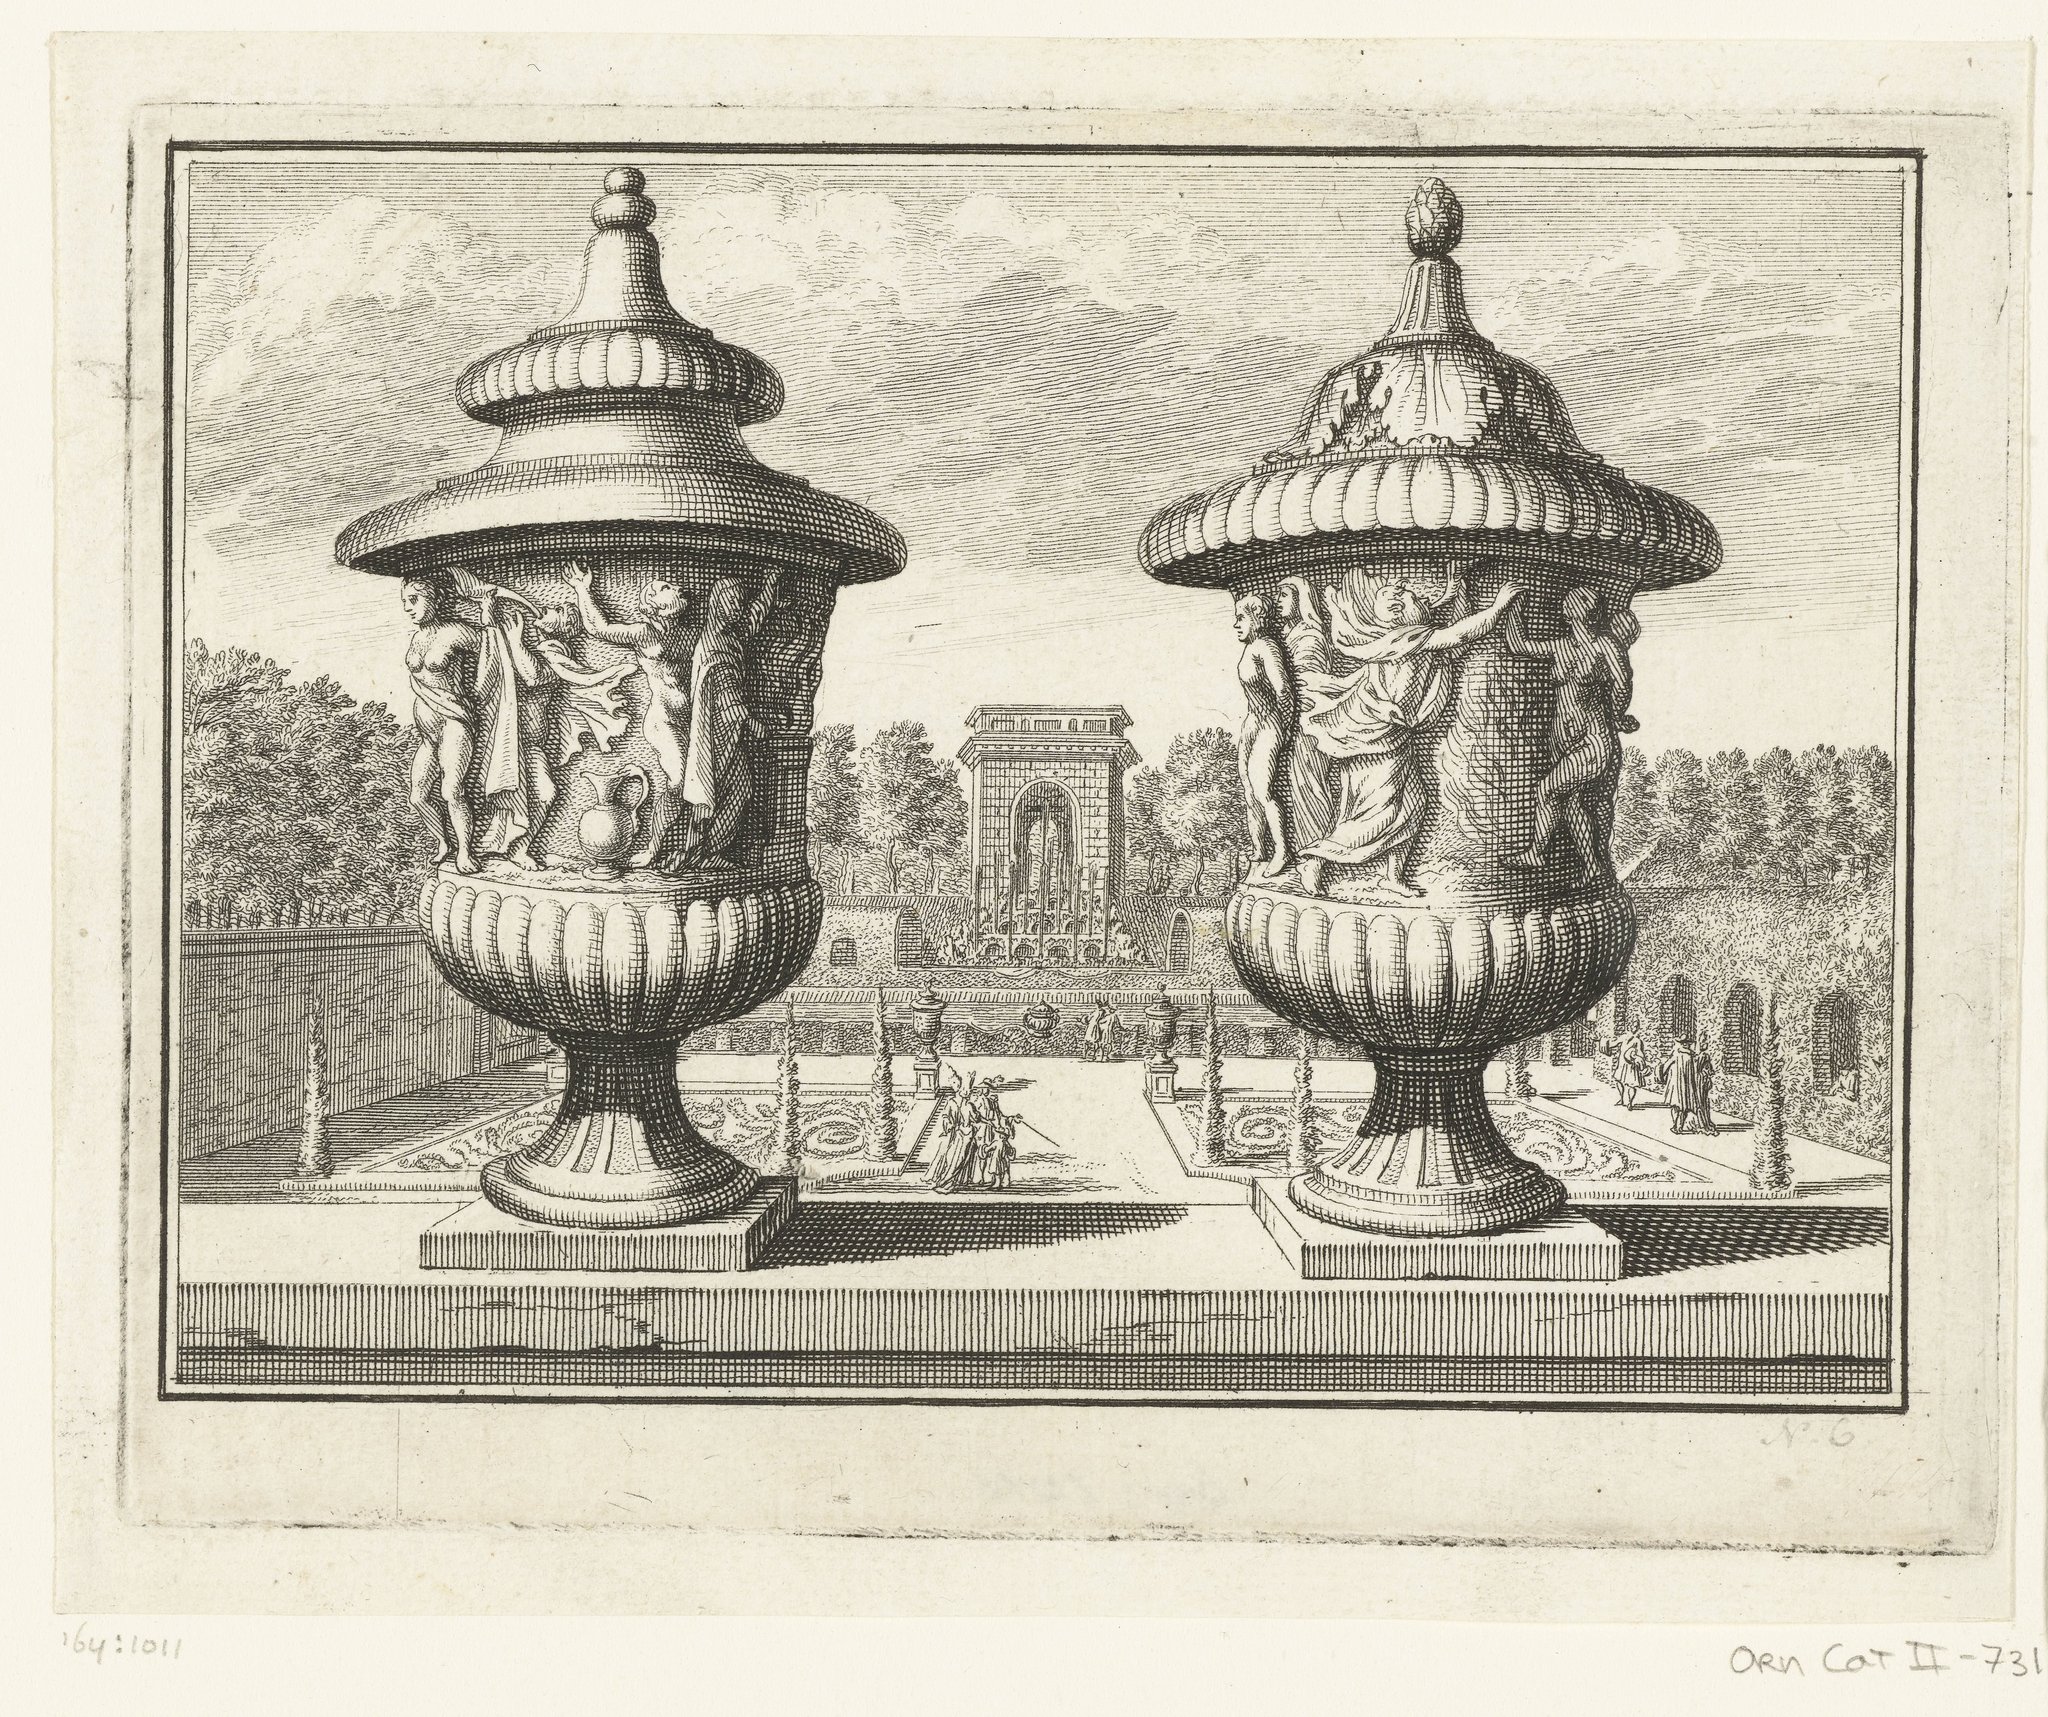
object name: print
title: Twee vazen voor de grot met cascades van Zorgvliet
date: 1665-1727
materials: paper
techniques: etching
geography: amsterdam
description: Beide vazen zijn gedecoreerd met een fries met offerscène. Uit serie van 7 bladen met op elk blad twee vazen op een balustrade met op de achtergrond uitzicht op de tuinen van Zorgvliet.